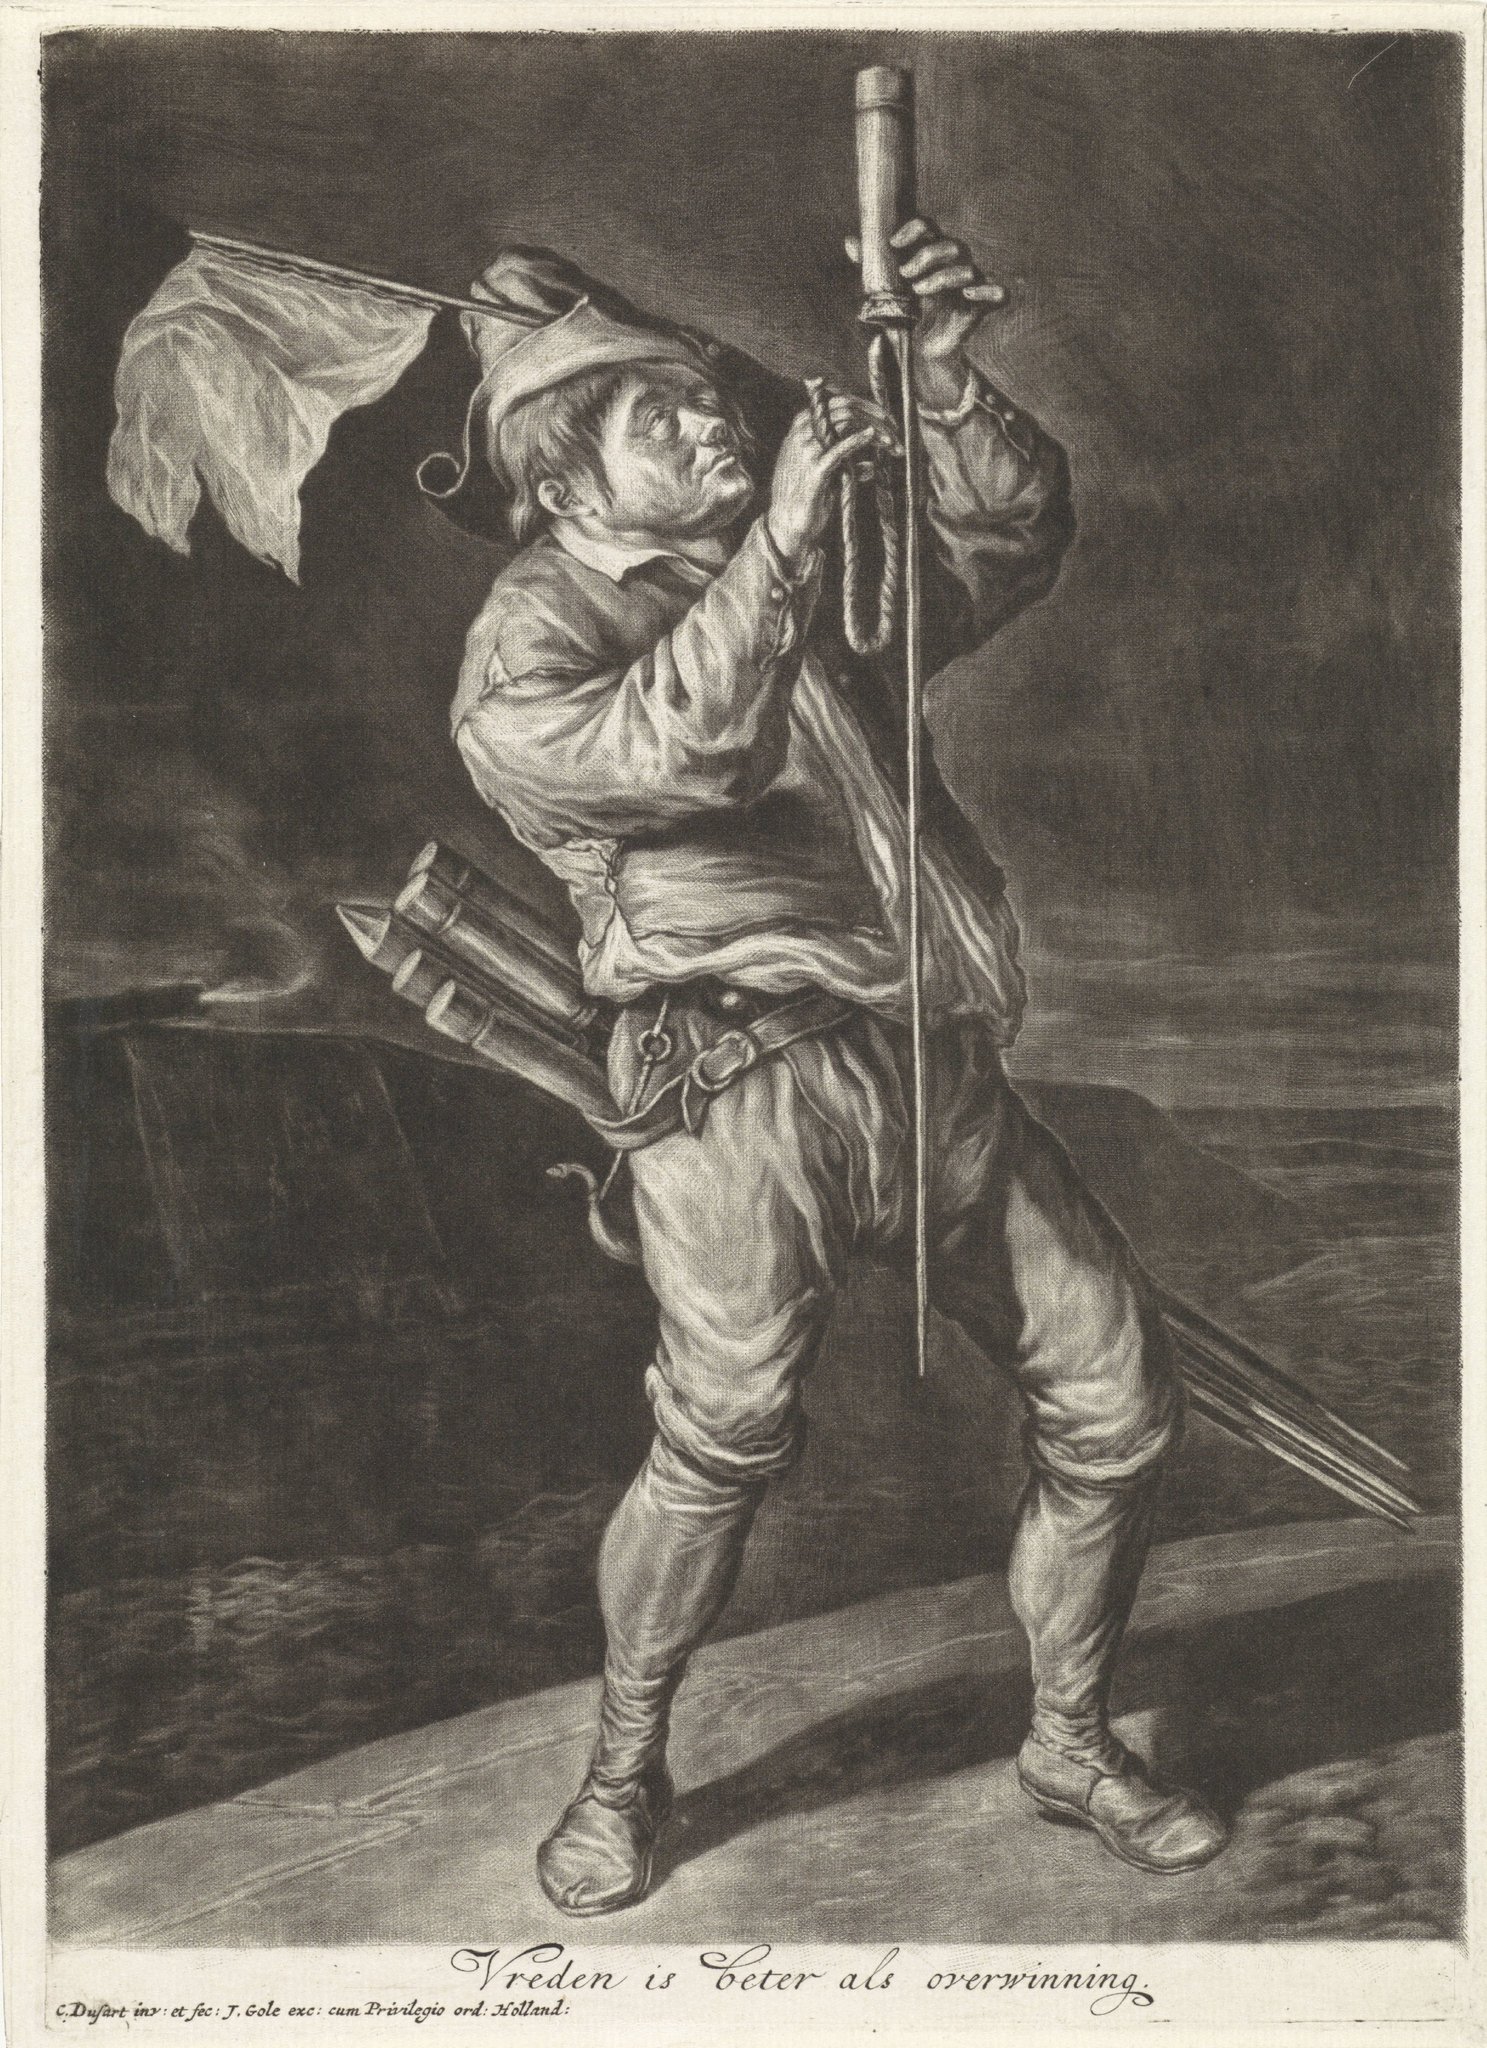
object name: print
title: De algemene blijdschap om de inname van Namen door stadhouder Willem III, koning van Engeland, september 1695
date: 1695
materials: paper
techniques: mezzotint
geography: amsterdam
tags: the hague, william iii (prince of orange and king of england, scotland, and ireland), bonfire, fire-works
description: Een man steekt met een lont een vuurpijl aan. De prent is onderdeel van een reeks van acht prenten vervaardigd naar aanleiding van de verovering van Namen door de geallieerden op 5 september 1695.